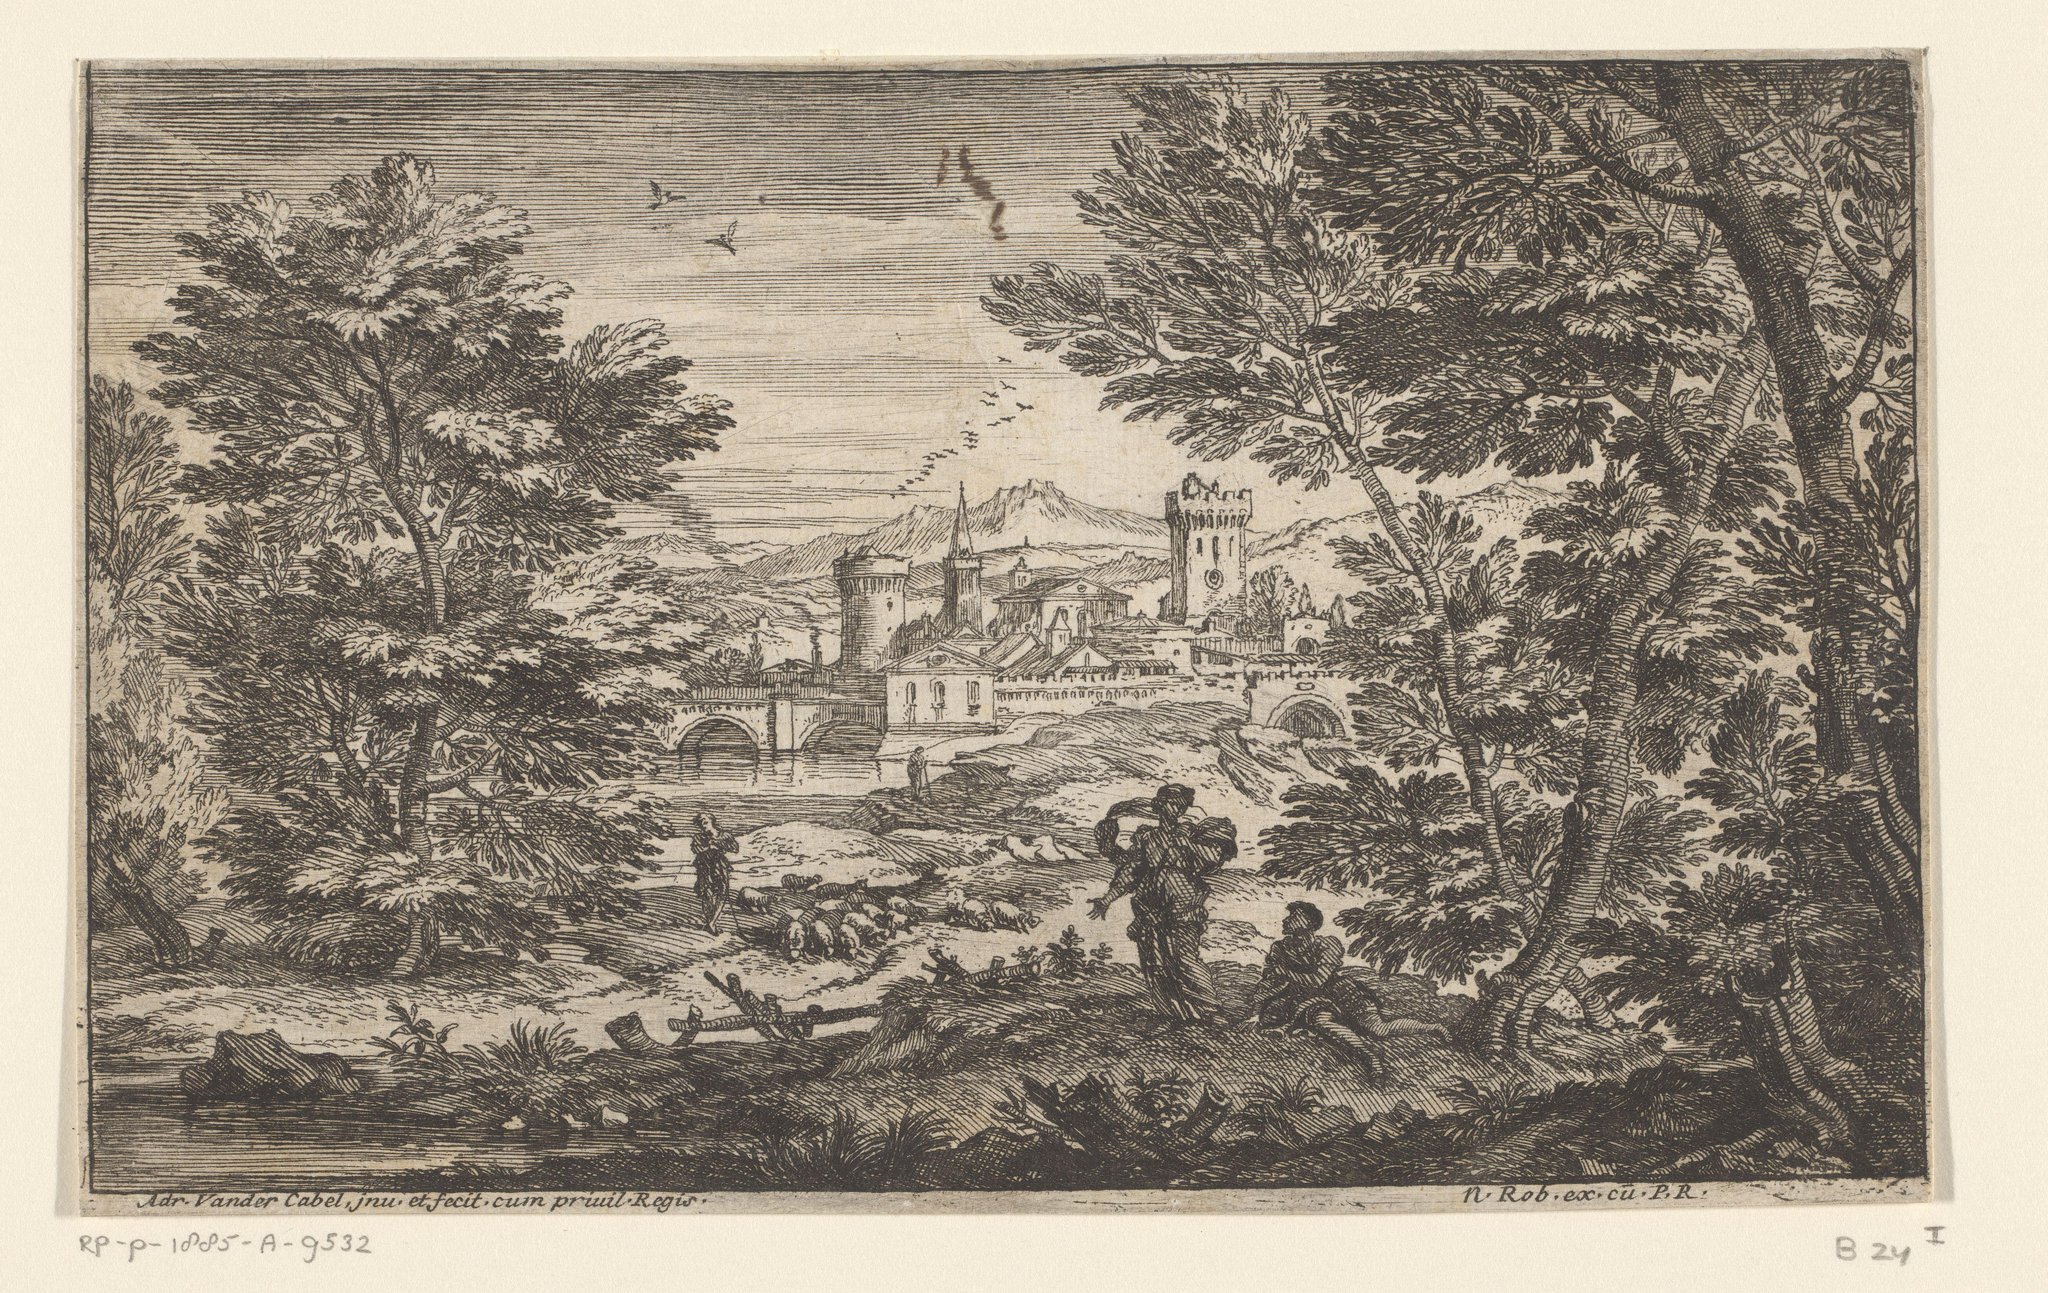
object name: print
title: De kudde in het midden der plaat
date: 1648-1705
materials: paper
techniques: etching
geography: france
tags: landscapes, herding, herdsman, herdswoman, shepherd, shepherdess, cowherd, etc.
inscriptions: collector's mark: Lugt 2228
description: Landschap met staande vrouw kijkend naar liggende man; verderop een schaapsherder met zijn kudde. Op de achtergrond een stad met brug over het water. Vijfde prent uit deserie van zes.